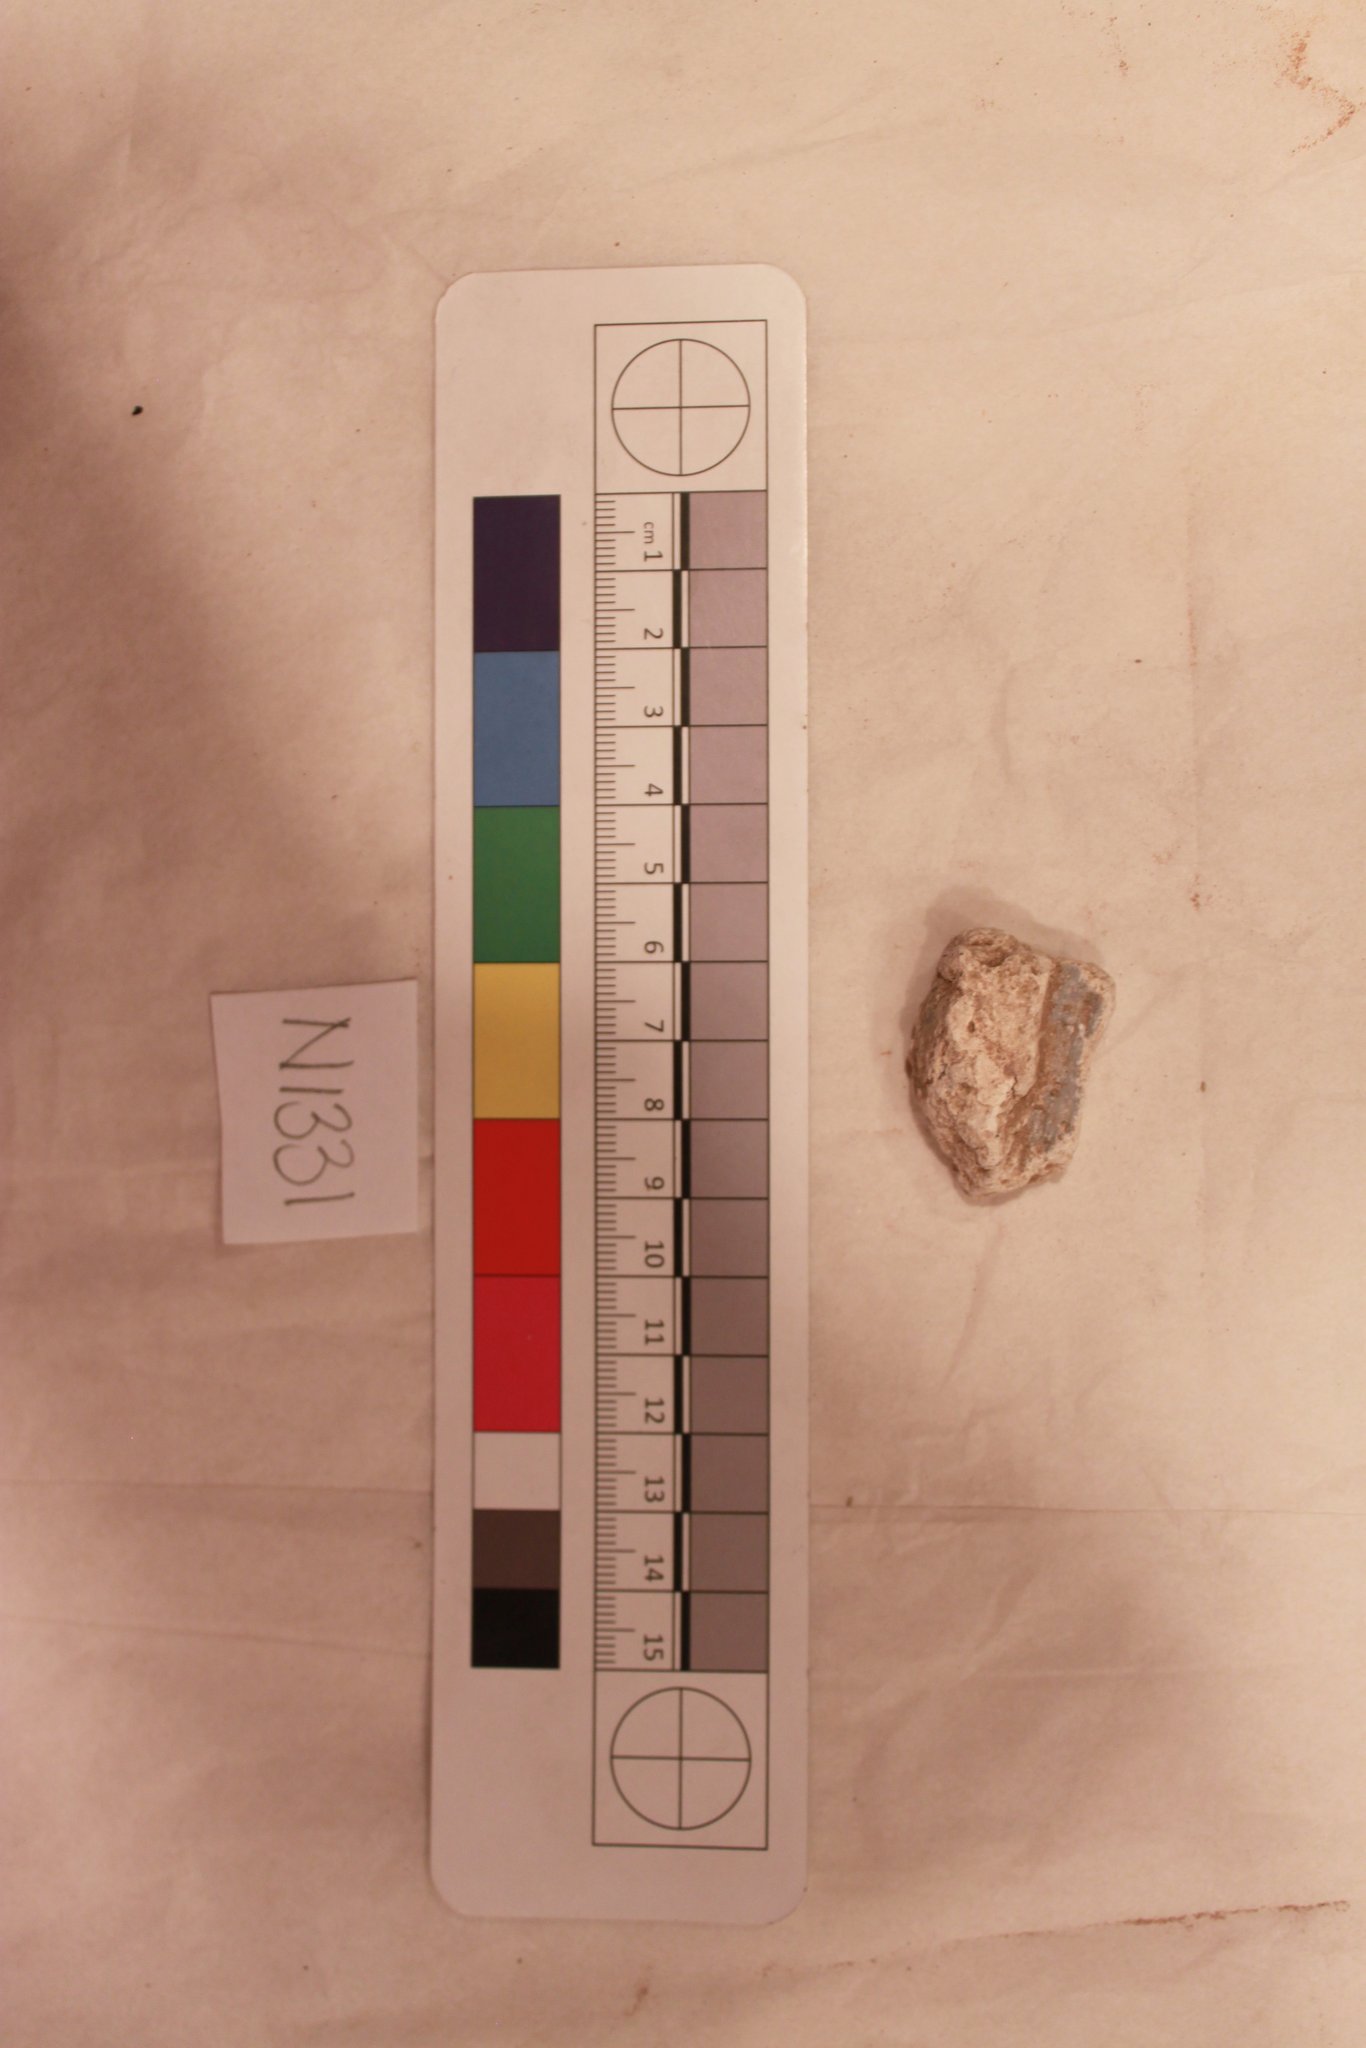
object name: fragment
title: Stucco Fragment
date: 701-1200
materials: plaster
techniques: carving, painting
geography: iran